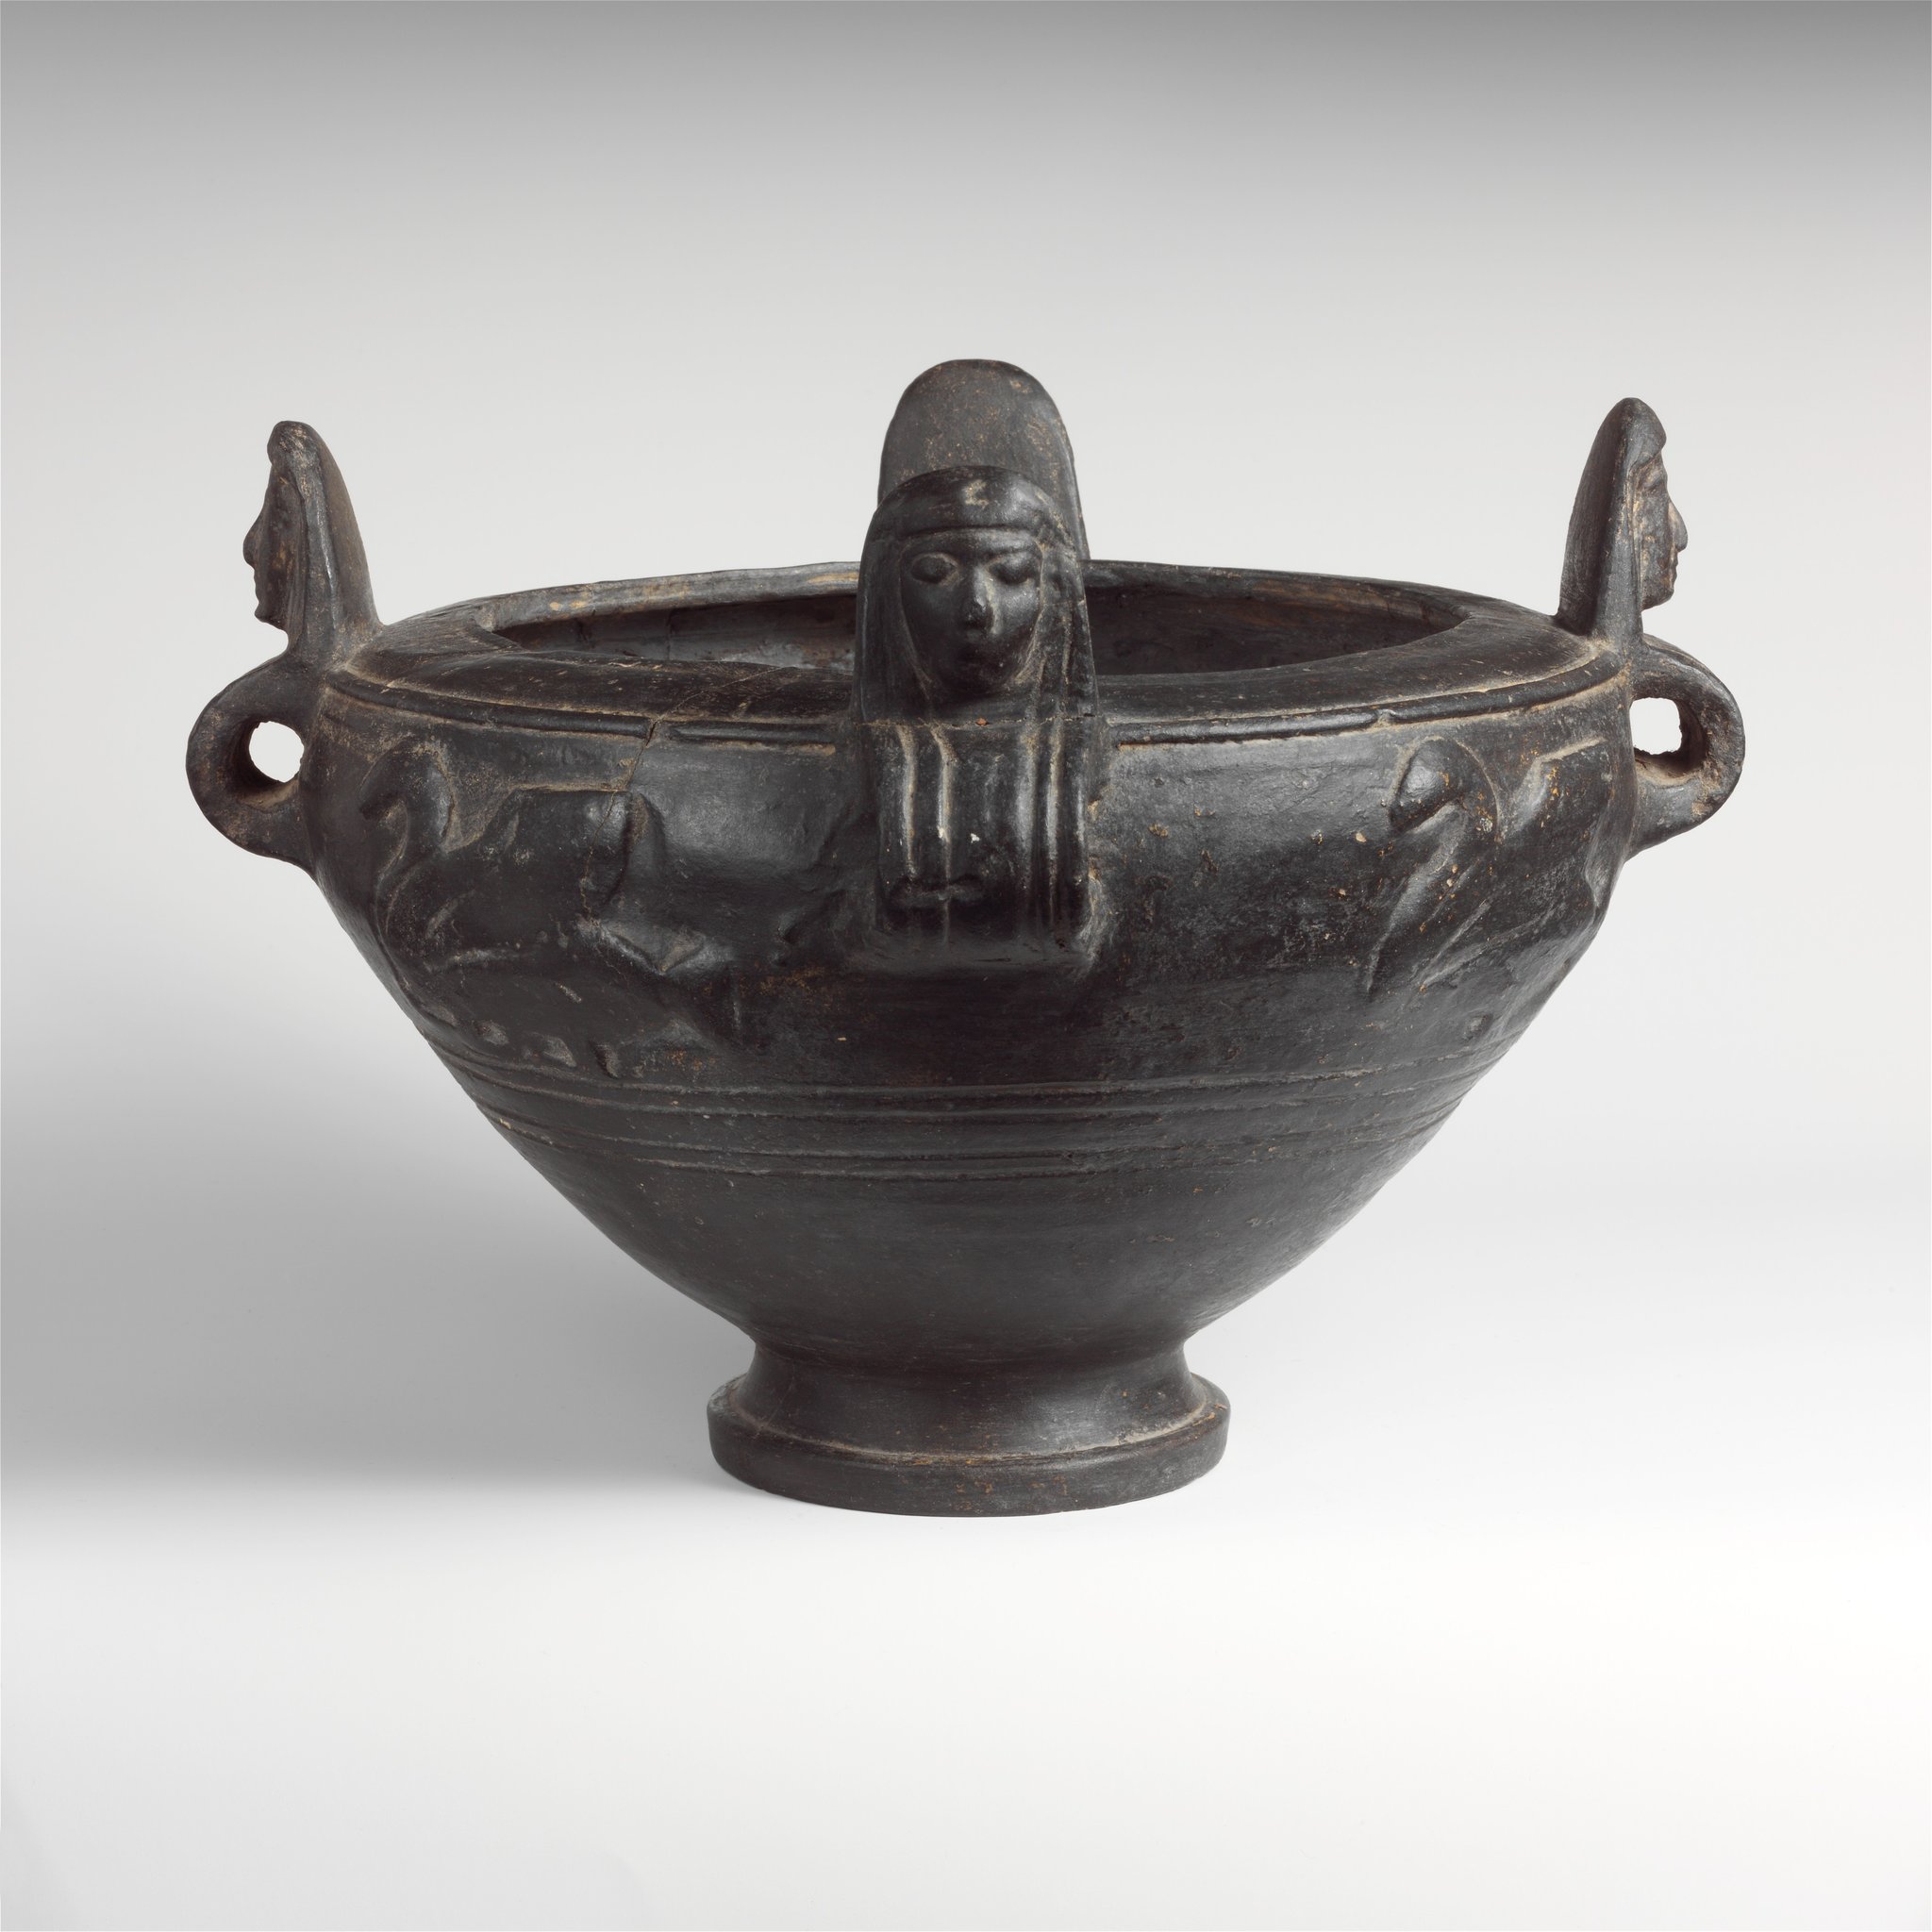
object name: bowl with lid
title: Terracotta bowl with lid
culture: etruscan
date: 534-501 BCE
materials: terracotta